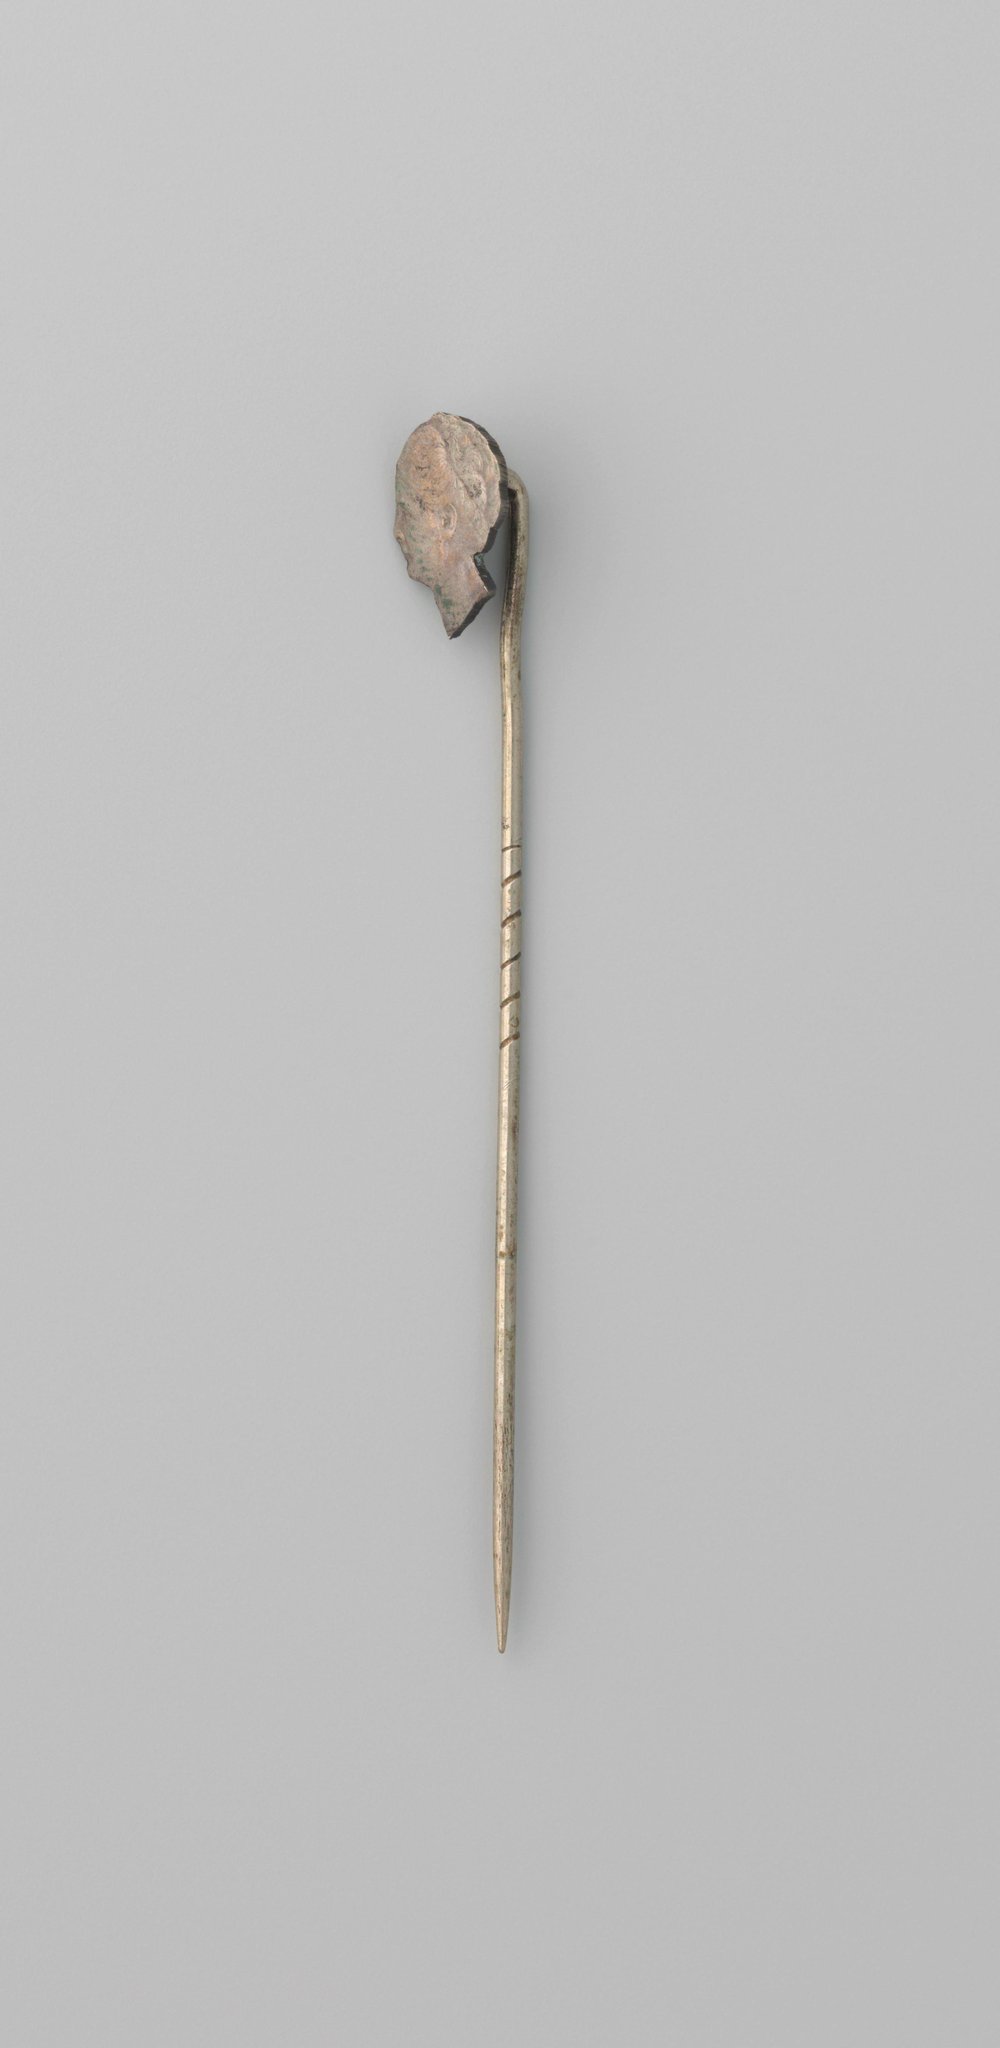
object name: lapel pin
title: Reversspeld met beeldenaar van Wilhelmina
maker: Anonymous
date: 1940-1950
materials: silver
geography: netherlands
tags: the hague, print maker, wilhelmina of the netherlands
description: Reversspeld met uitgezaagde beeldenaar van Wilhelmina zonder rand.